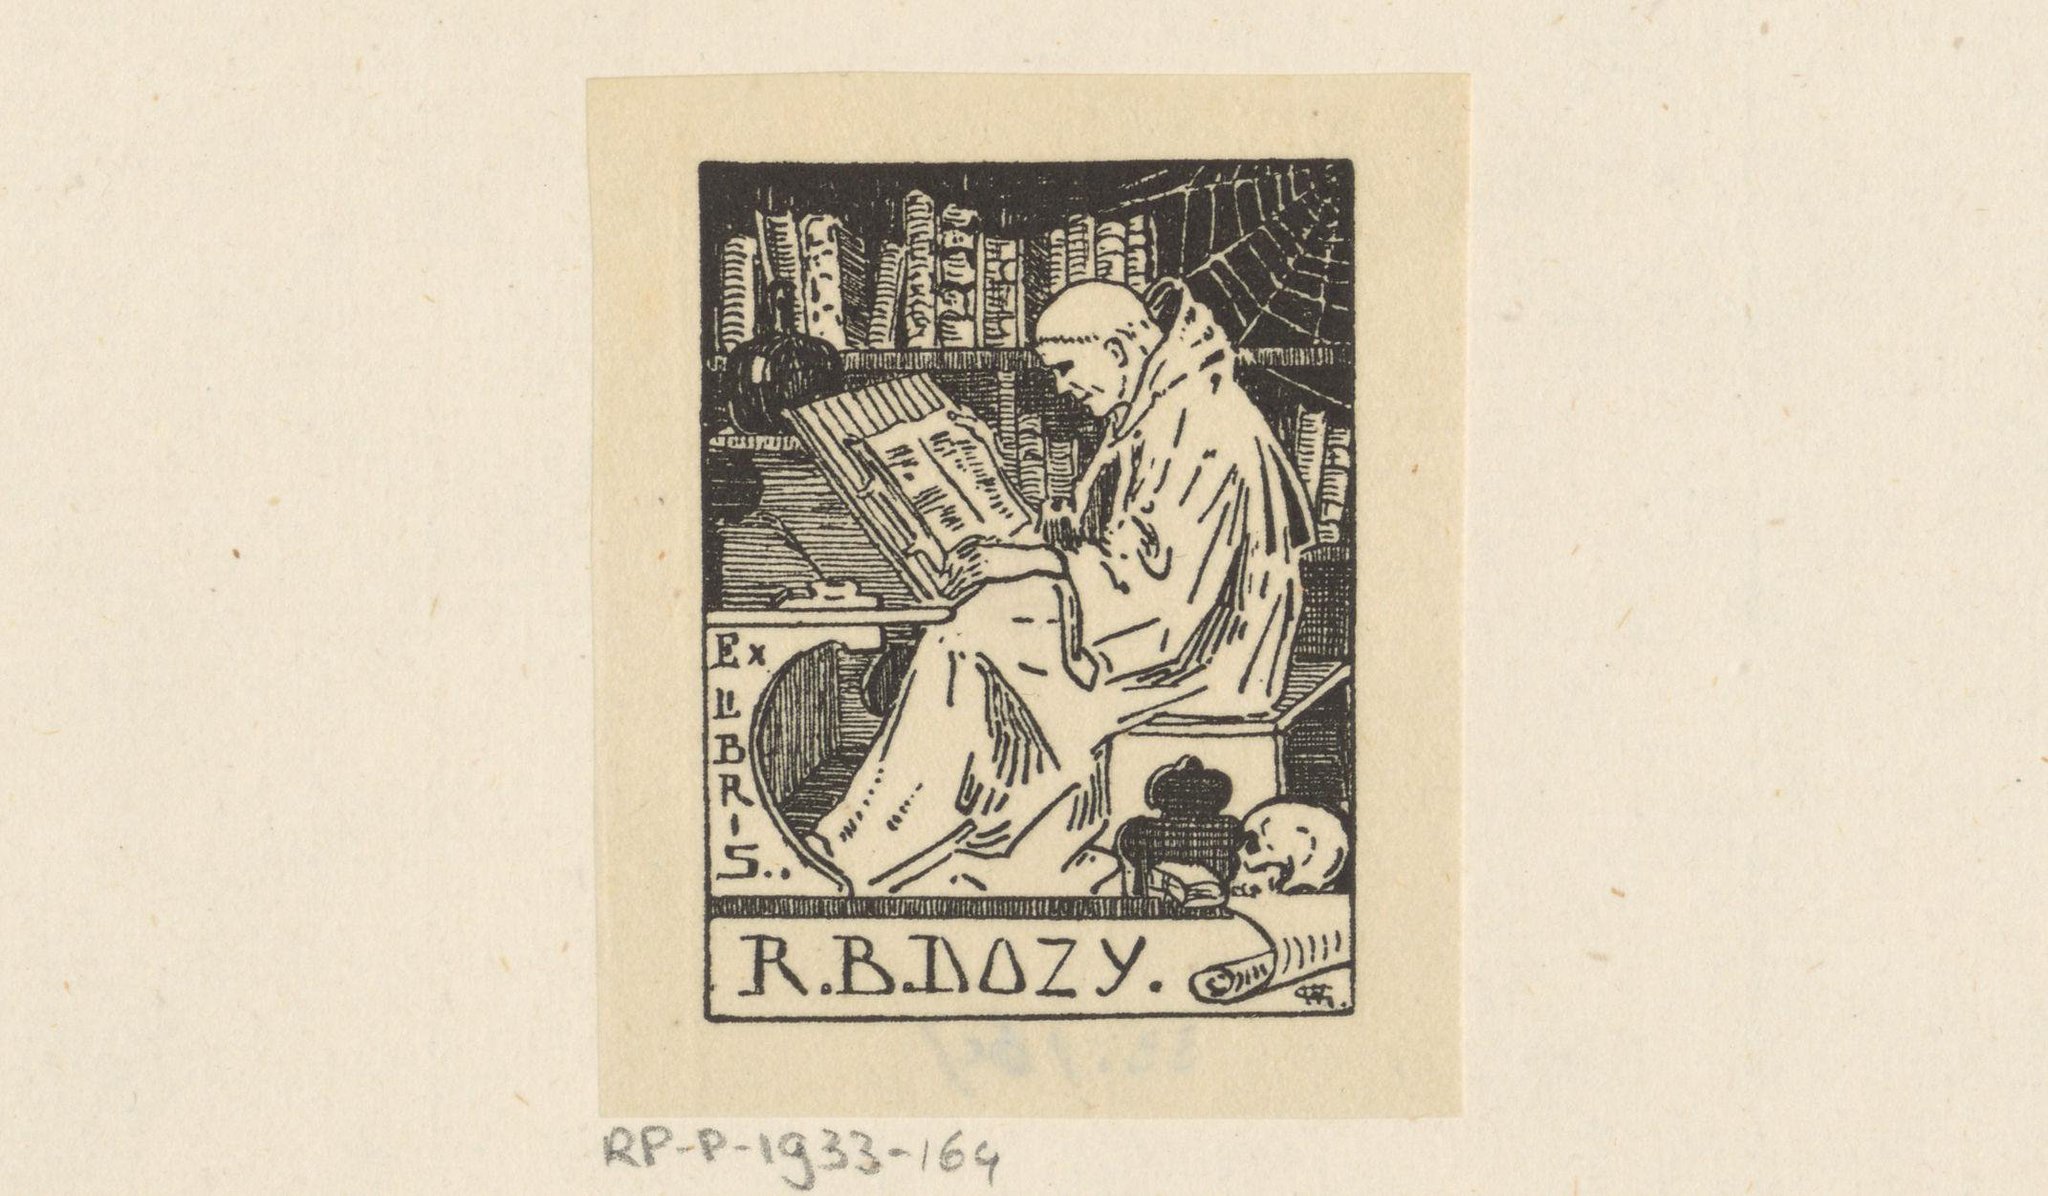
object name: bookplate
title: Ex libris van R.B. Dozy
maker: willem adrianus grondhout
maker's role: draughtsman, painter, print maker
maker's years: 1878-1934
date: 1888-1933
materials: paper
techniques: printing block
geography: netherlands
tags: monk(s), friar(s), study; 'studiolo'; library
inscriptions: collector's mark: Lugt 2760